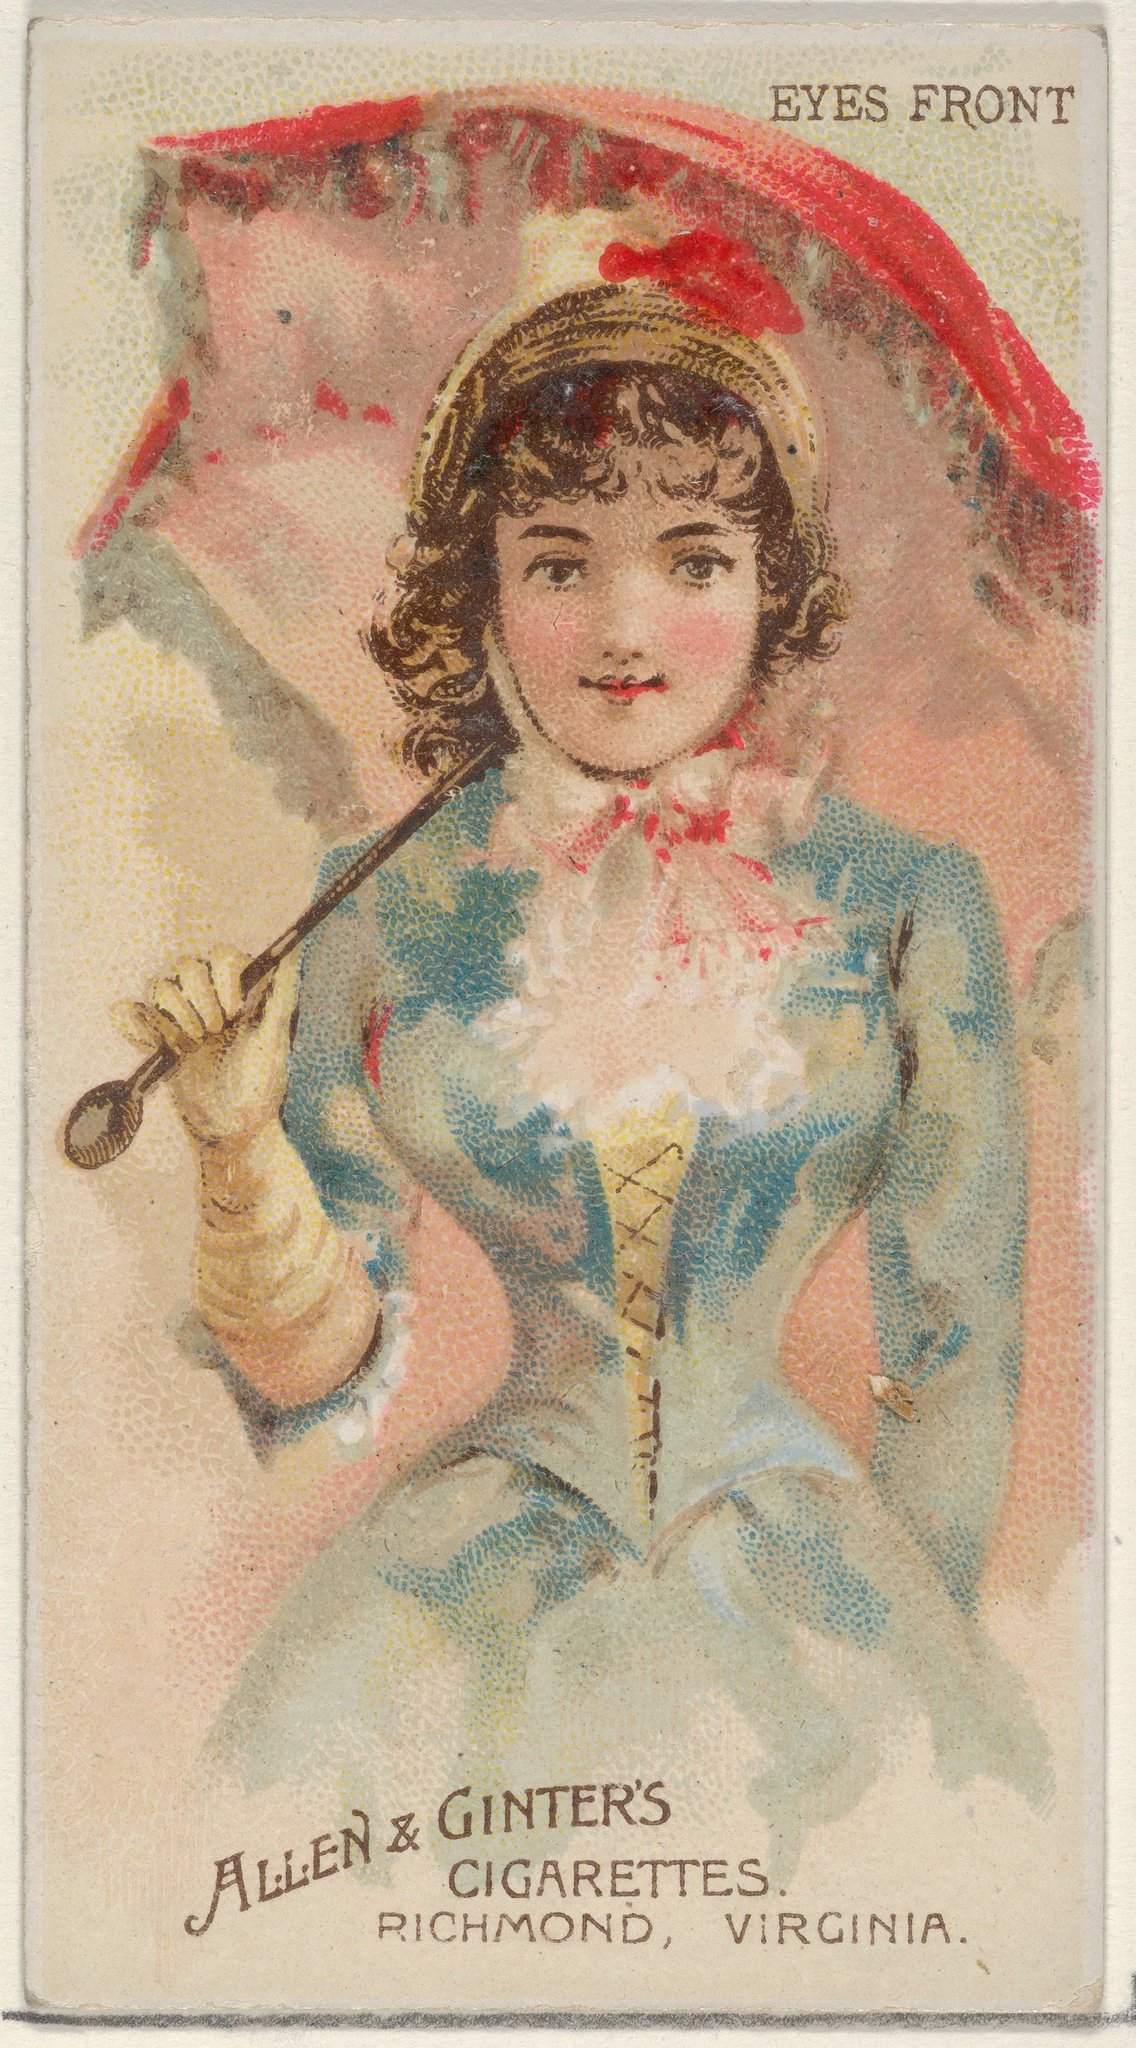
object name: print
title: Eyes Front, from the Parasol Drills series (N18) for Allen & Ginter Cigarettes Brands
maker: allen & ginter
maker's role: publisher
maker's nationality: american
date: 1888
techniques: color lithograph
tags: women